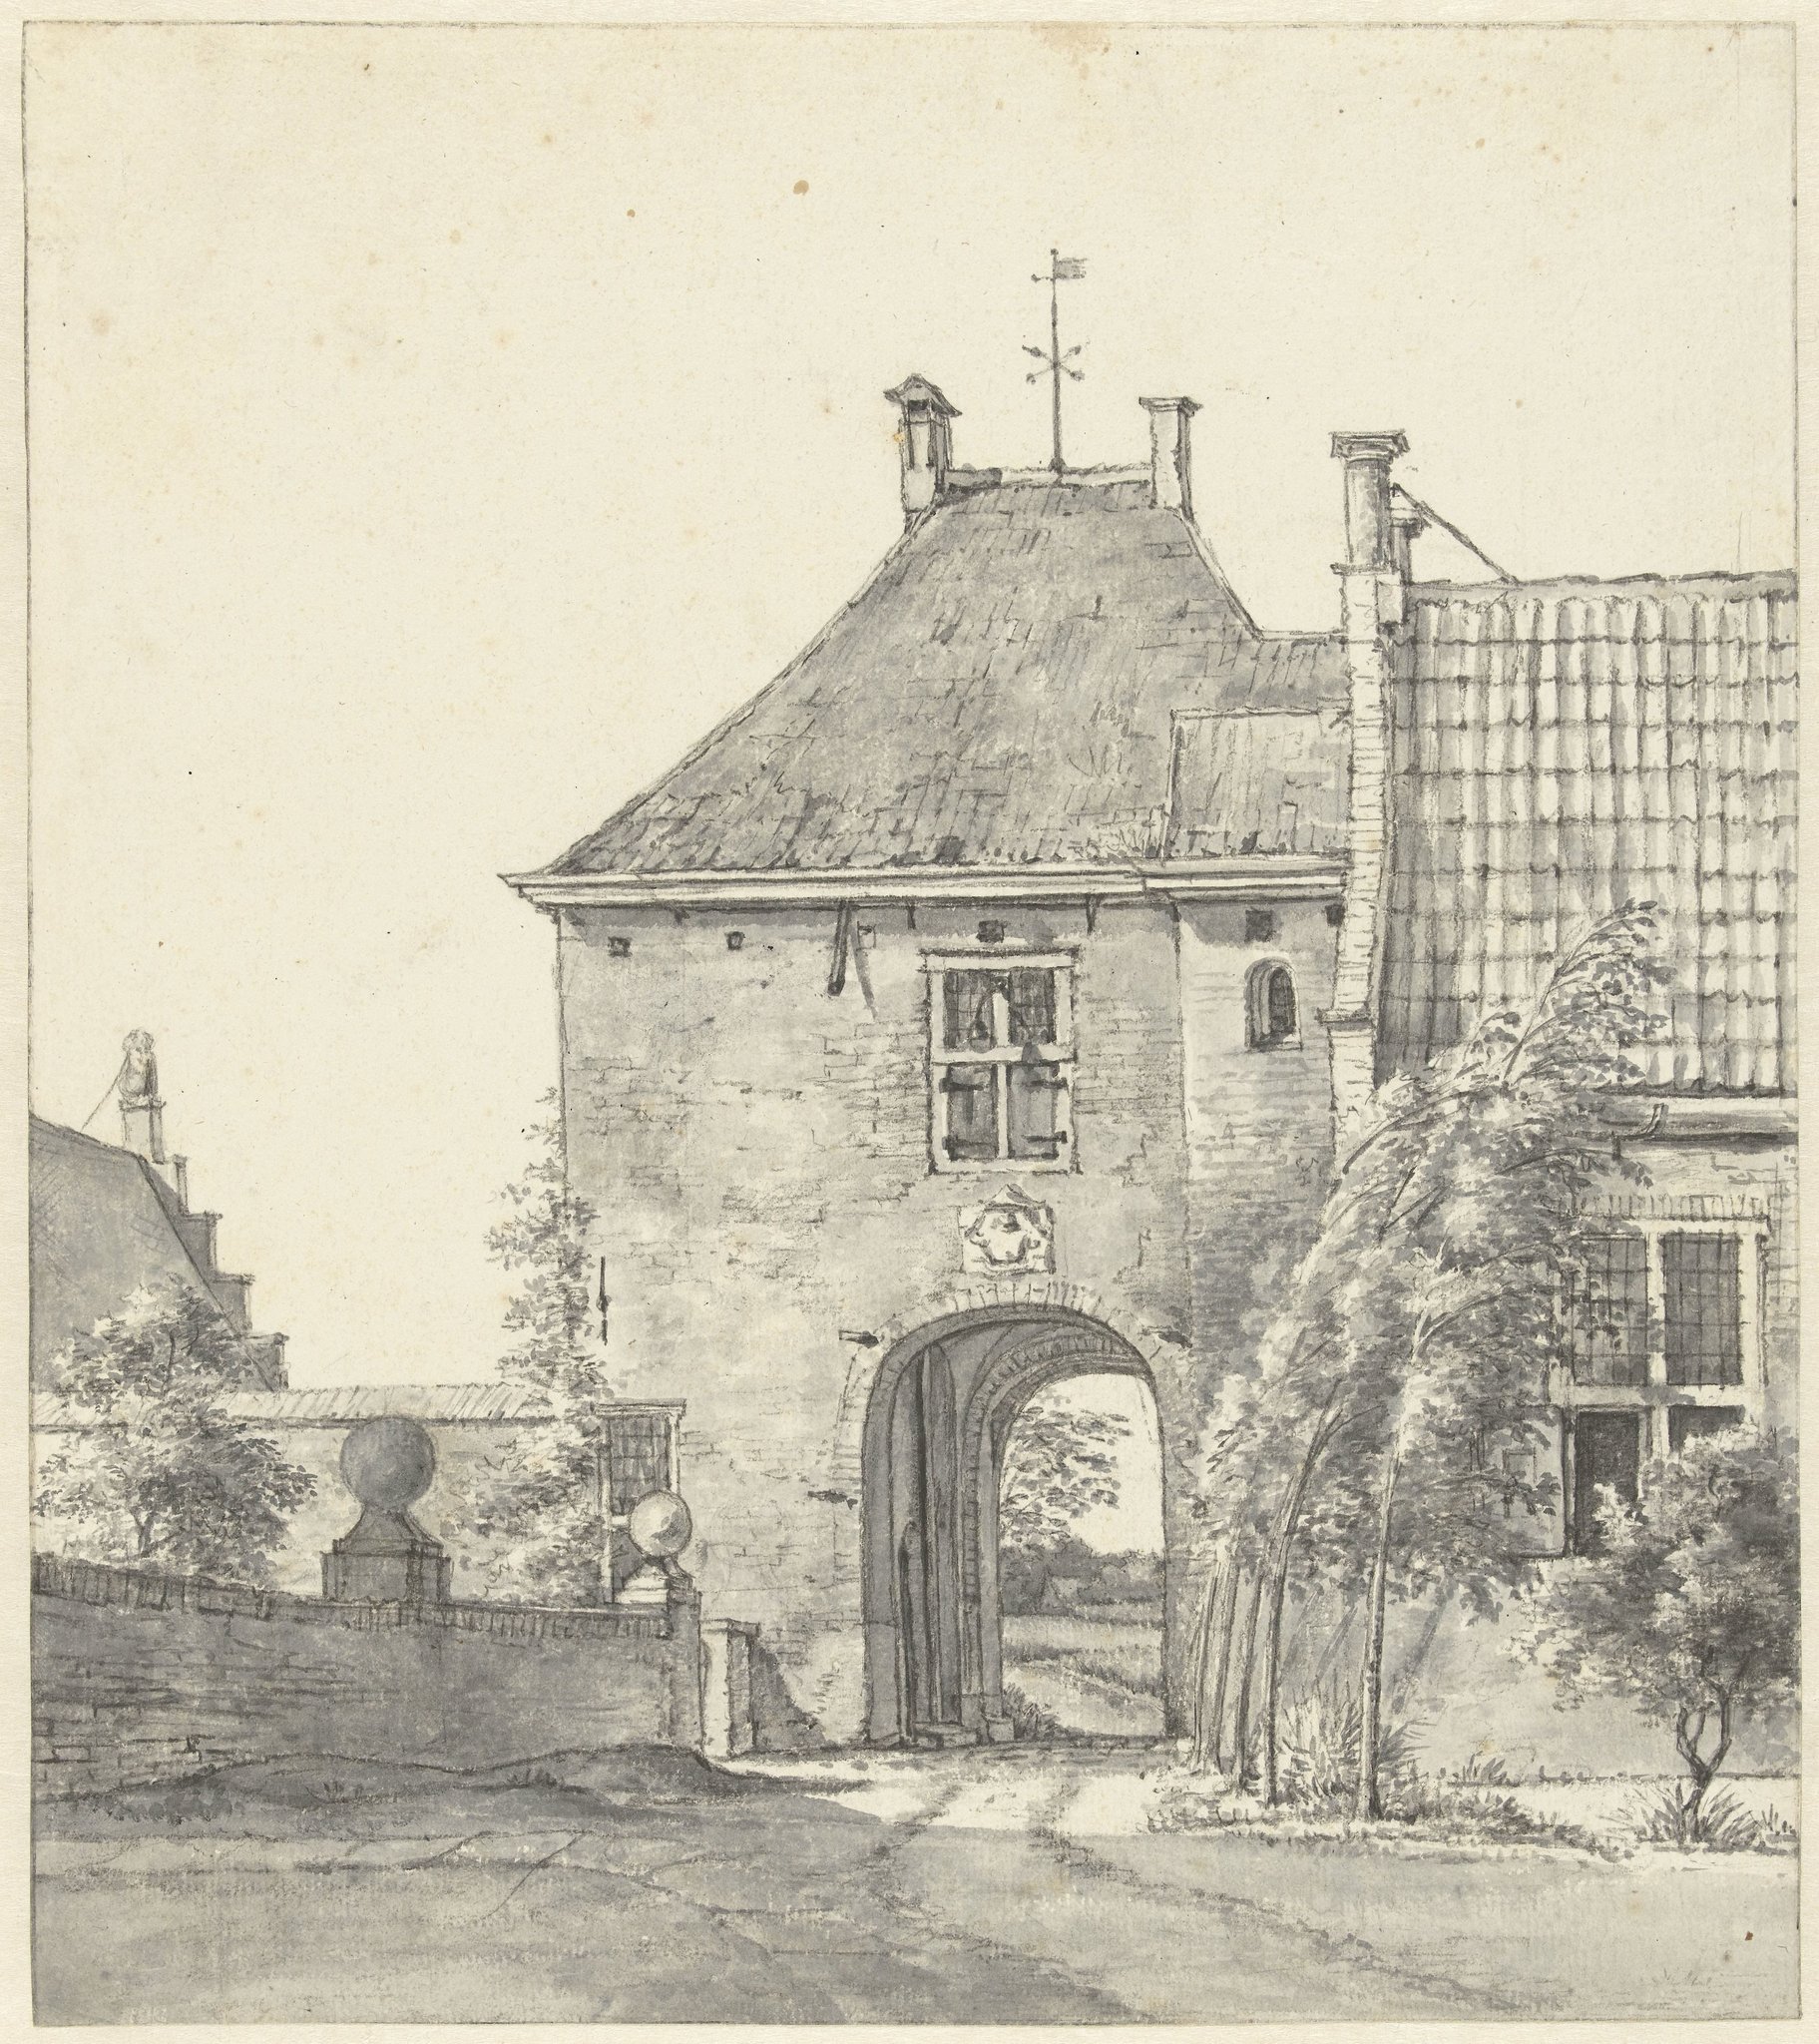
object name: drawing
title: De poort van het kasteel Heemstede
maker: gerrit lamberts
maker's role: bookseller, draughtsman, print maker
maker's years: 1776-1850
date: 1786-1850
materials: chalk, paper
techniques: brush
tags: castle